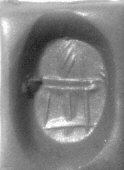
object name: stamp seal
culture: sasanian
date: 201-300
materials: gemstone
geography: iran